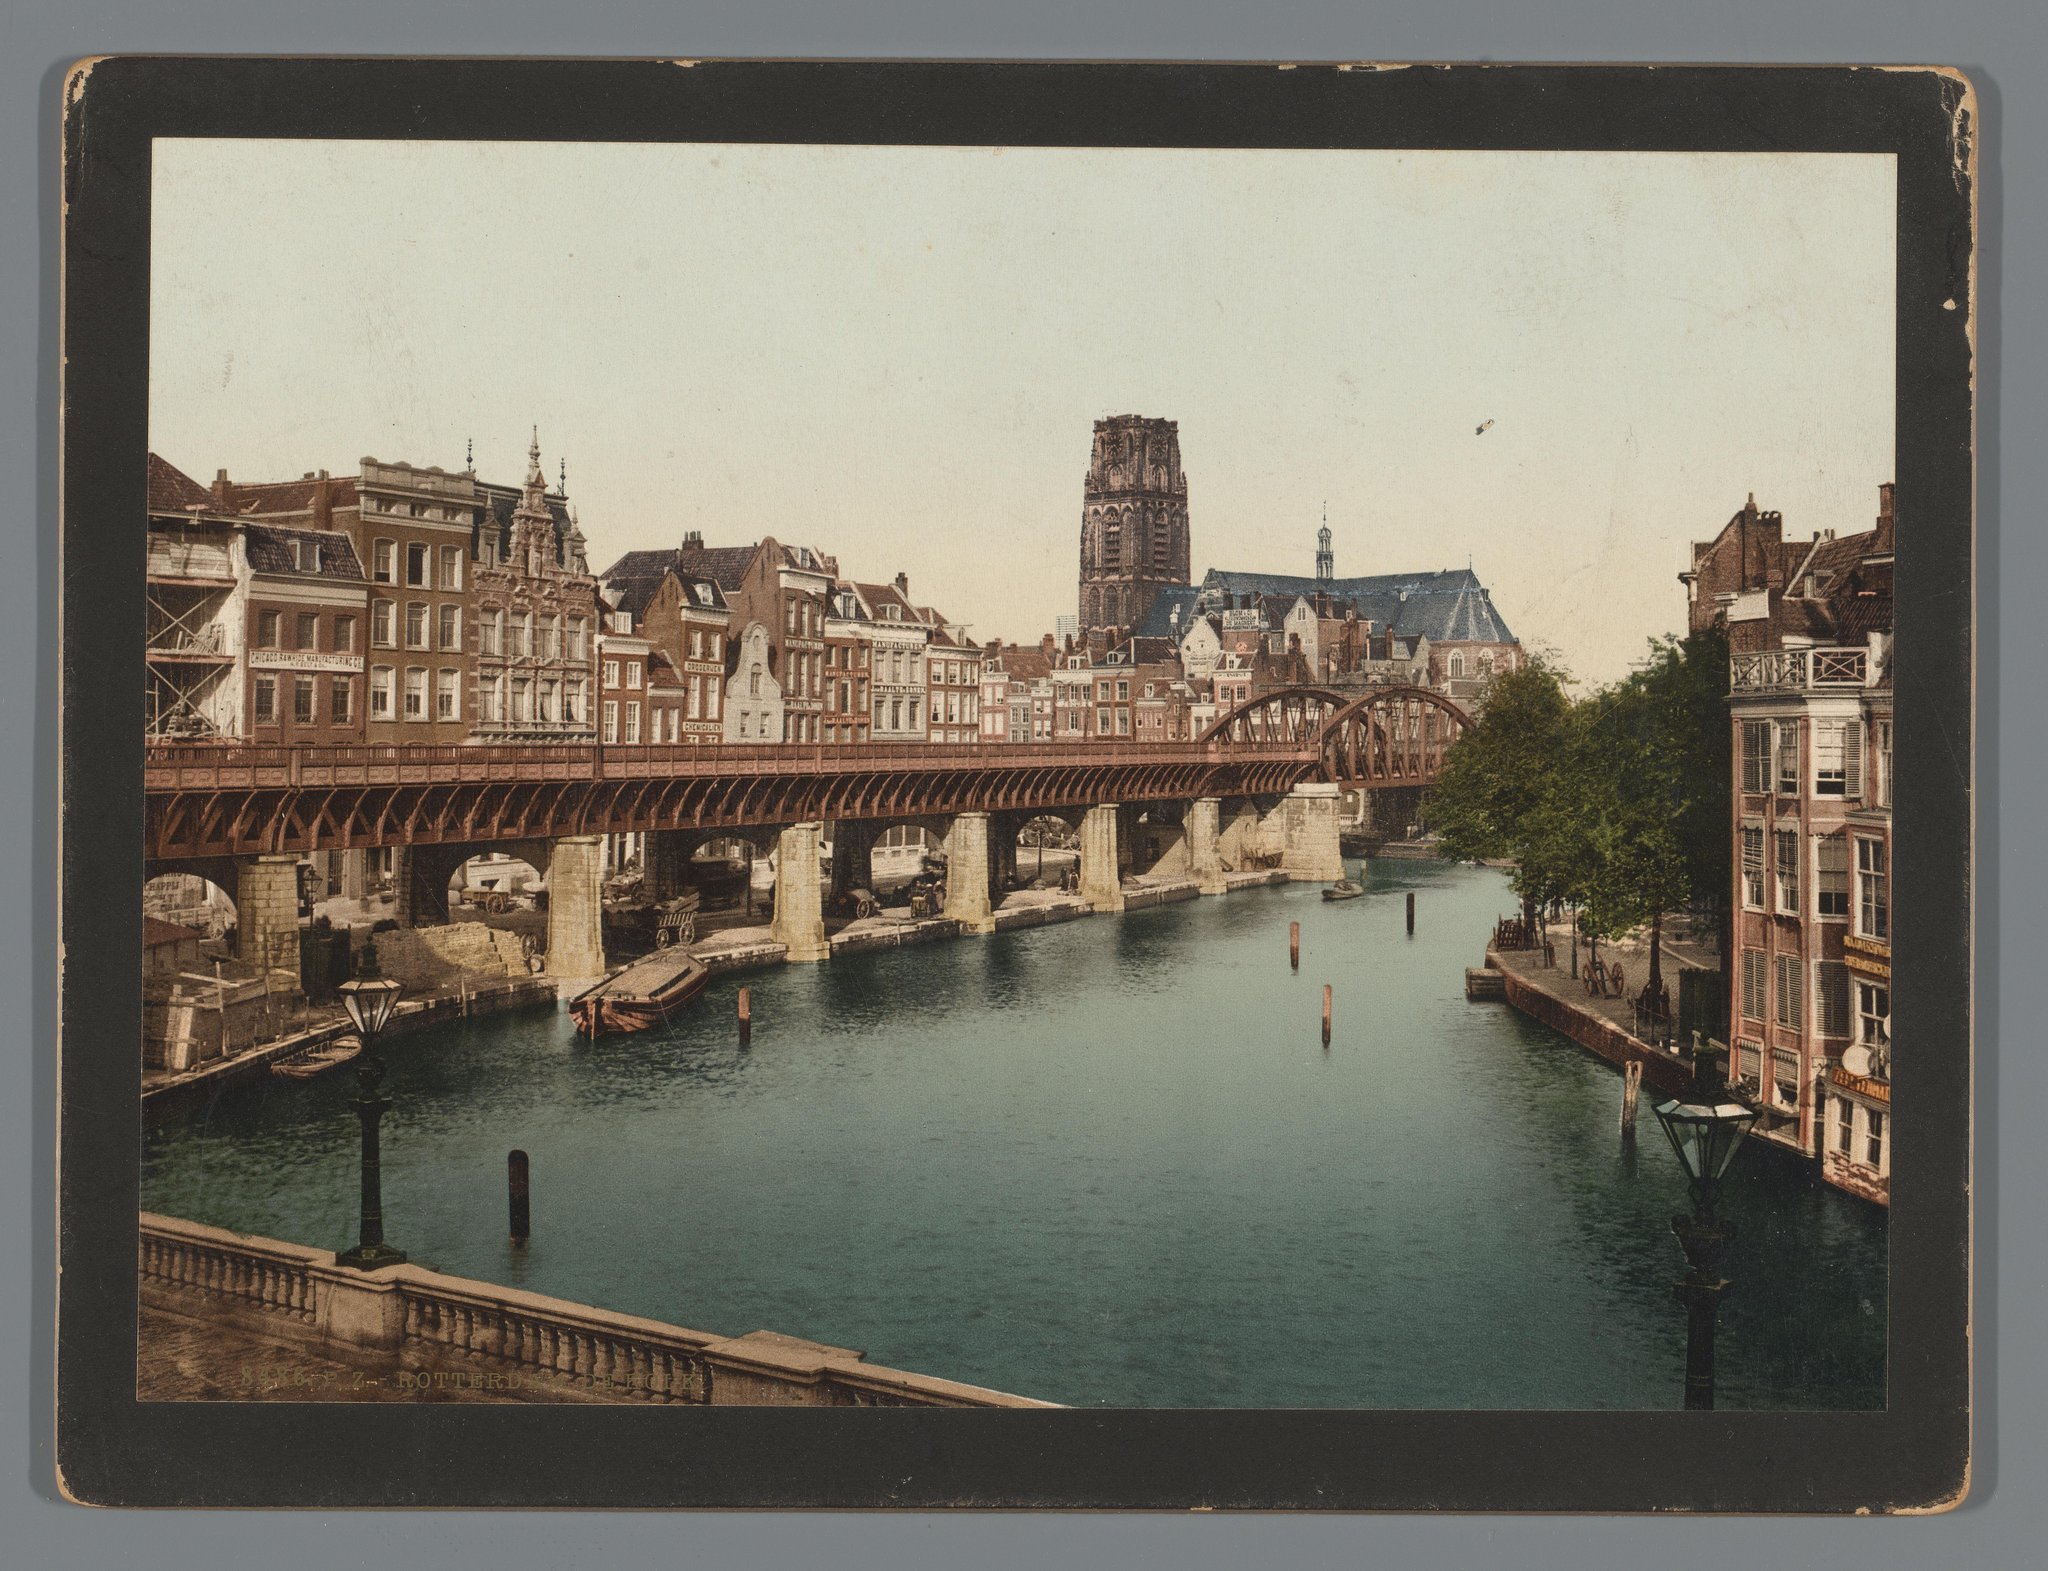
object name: photomechanical print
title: Kolk, Rotterdam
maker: Anonymous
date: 1889-1920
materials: cardboard, paper, photographic process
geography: zurich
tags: church (exterior), canals, waters (in city)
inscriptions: inscription: ‘Photochrom’, number: ‘8486.’